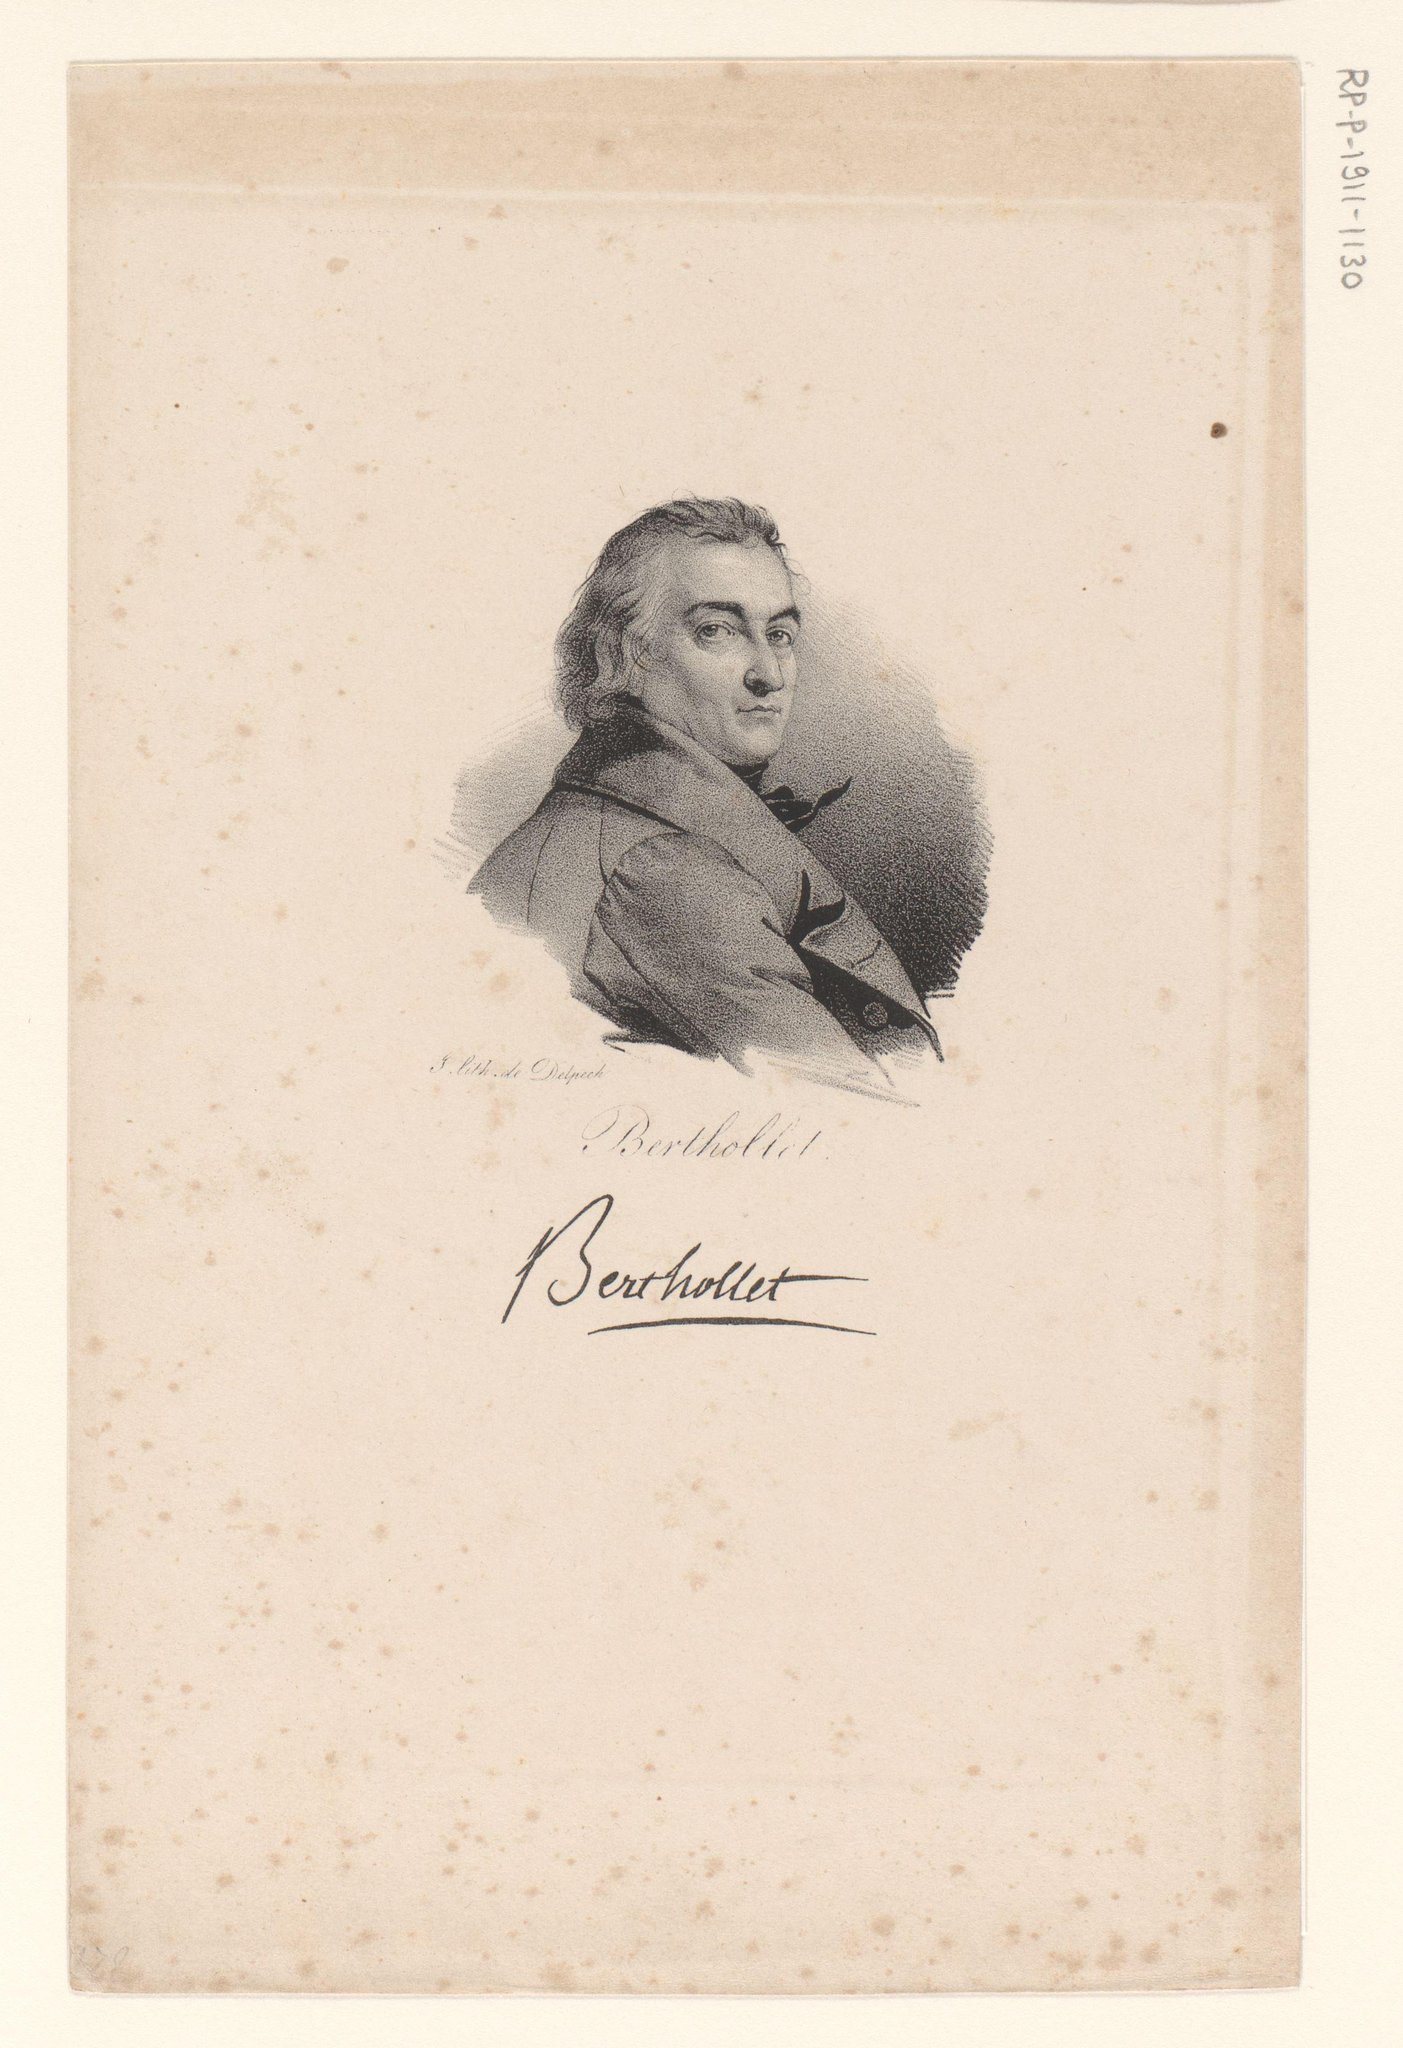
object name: print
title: Portret van Claude-Louis Berthollet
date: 1818-1842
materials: paper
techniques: lithograph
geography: paris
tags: historical persons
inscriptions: collector's mark: Lugt 2228a